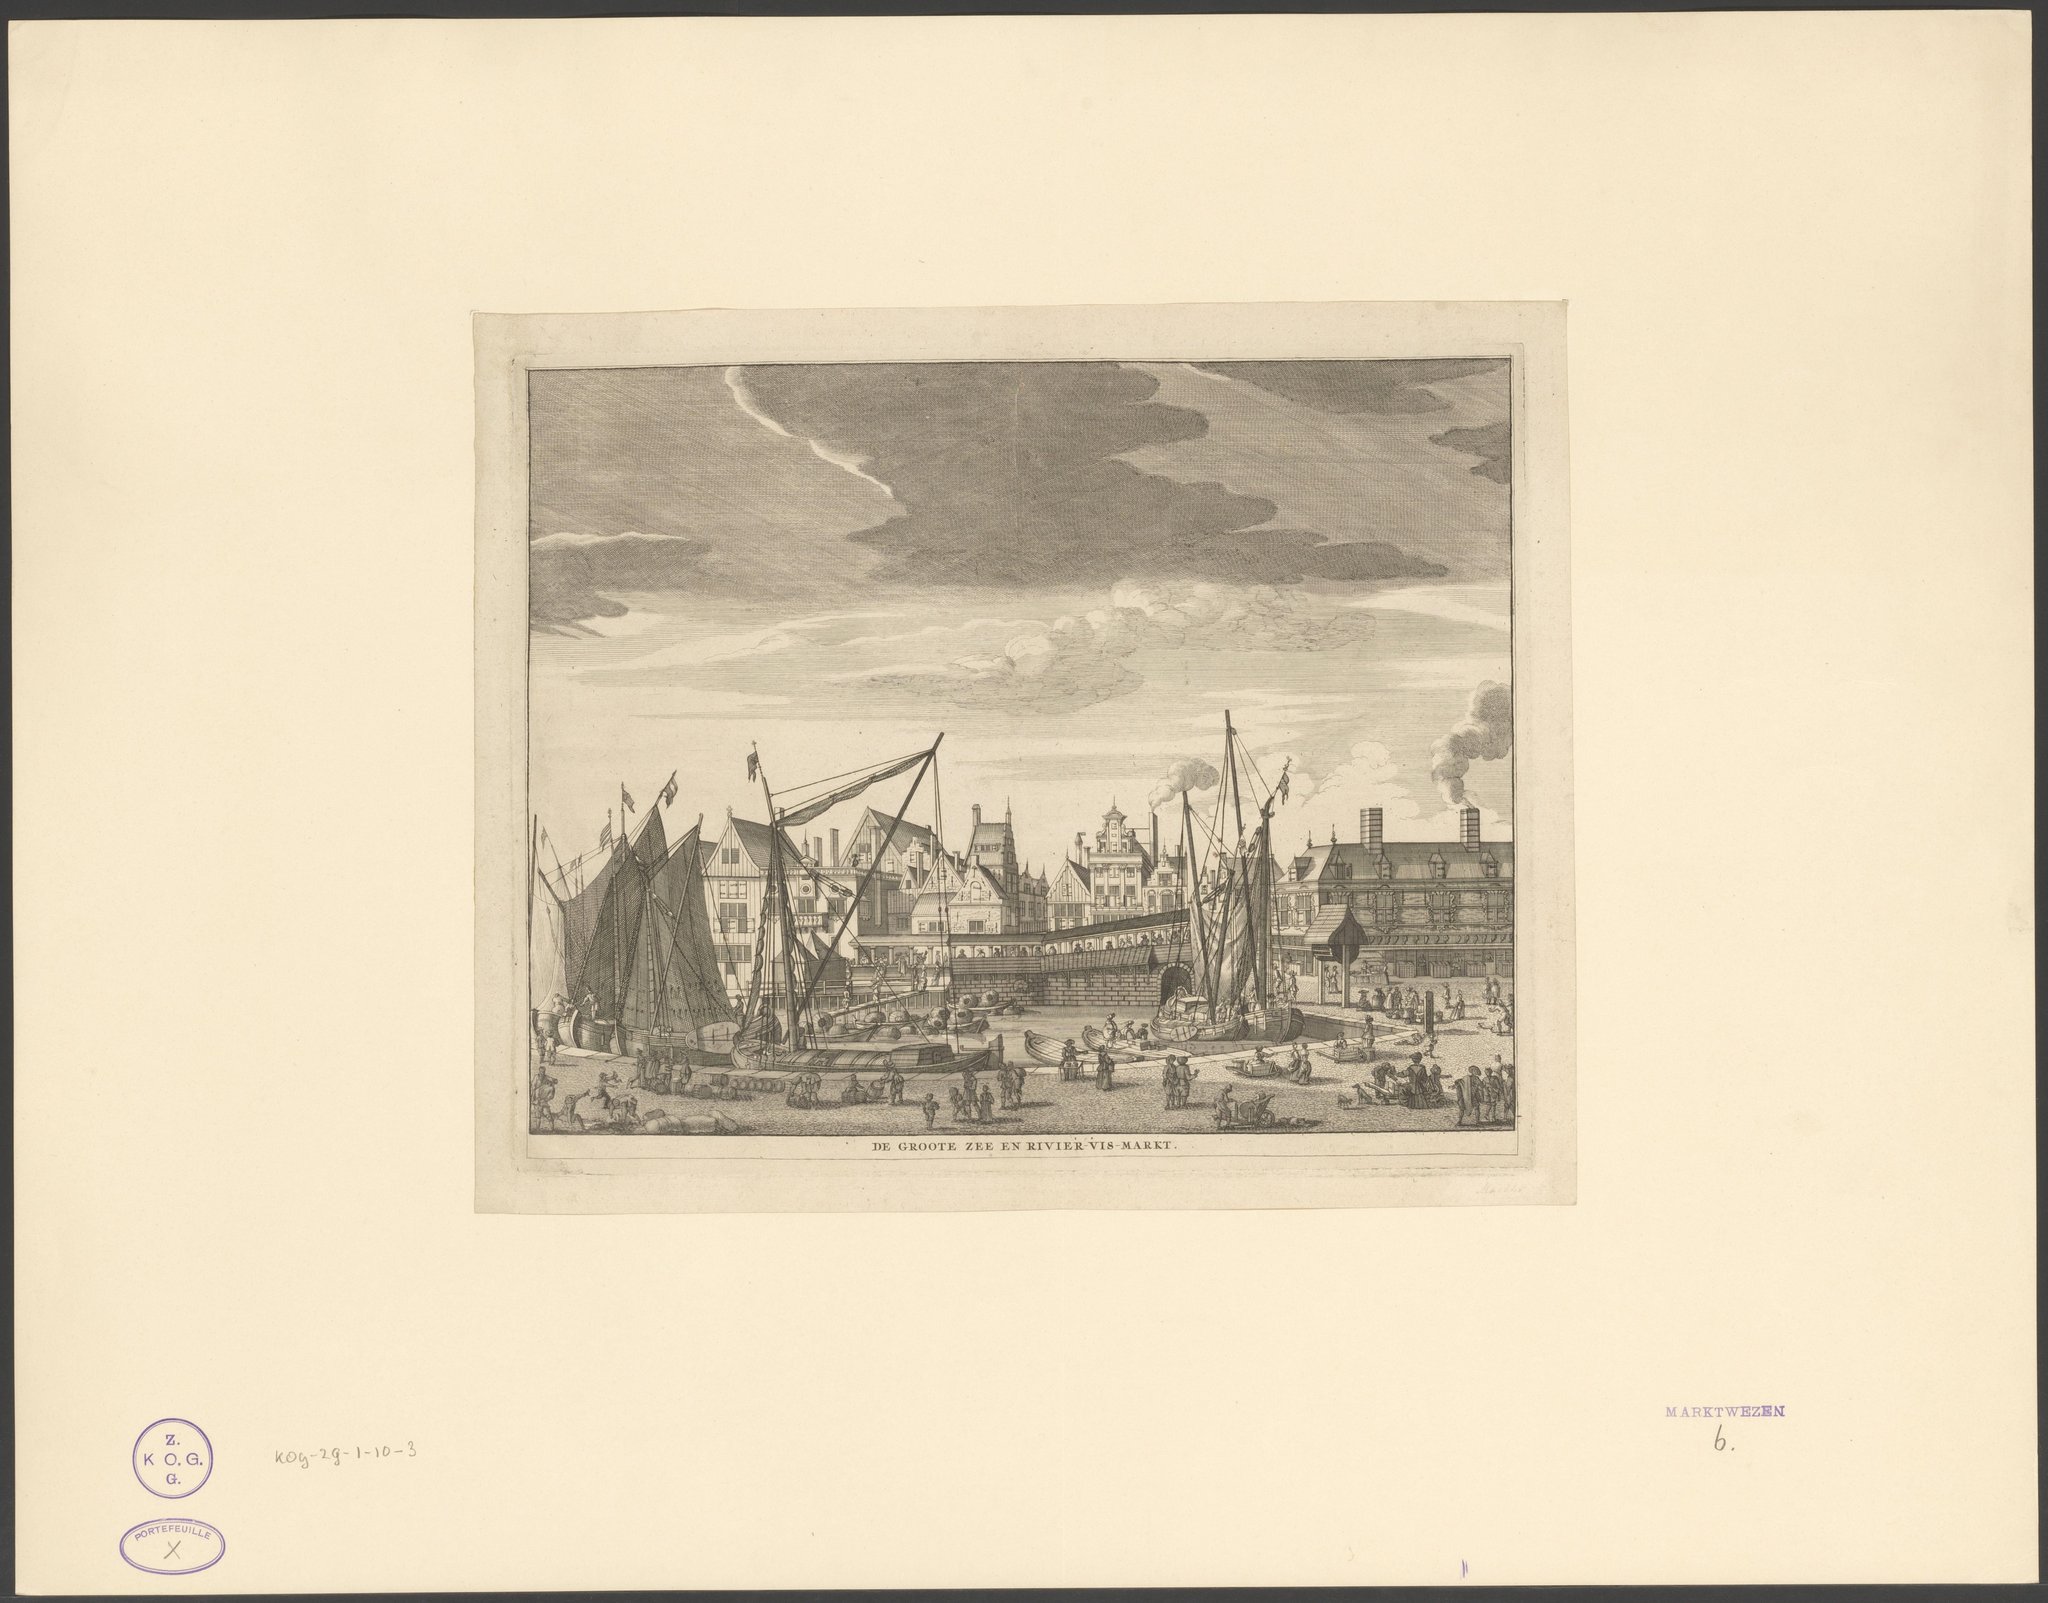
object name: print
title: De groote zee en rivier-vis-markt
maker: Anonymous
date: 1724-1726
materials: paper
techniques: etching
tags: herring fishery, canal, market, amsterdam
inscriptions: stamp, collector's mark: Lugt 1641, stamp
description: Prent waarschijnlijk uit: Commelin, Caspar. Beschryvinge van Amsterdam, zynde een naukeurige verhandelinge van desselfs eerste oorspronk uyt (…). Amsterdam: Andries van Damme et al., 1726. Prent komt in een eerdere staat voor in publicaties uit 1693 en 1694.